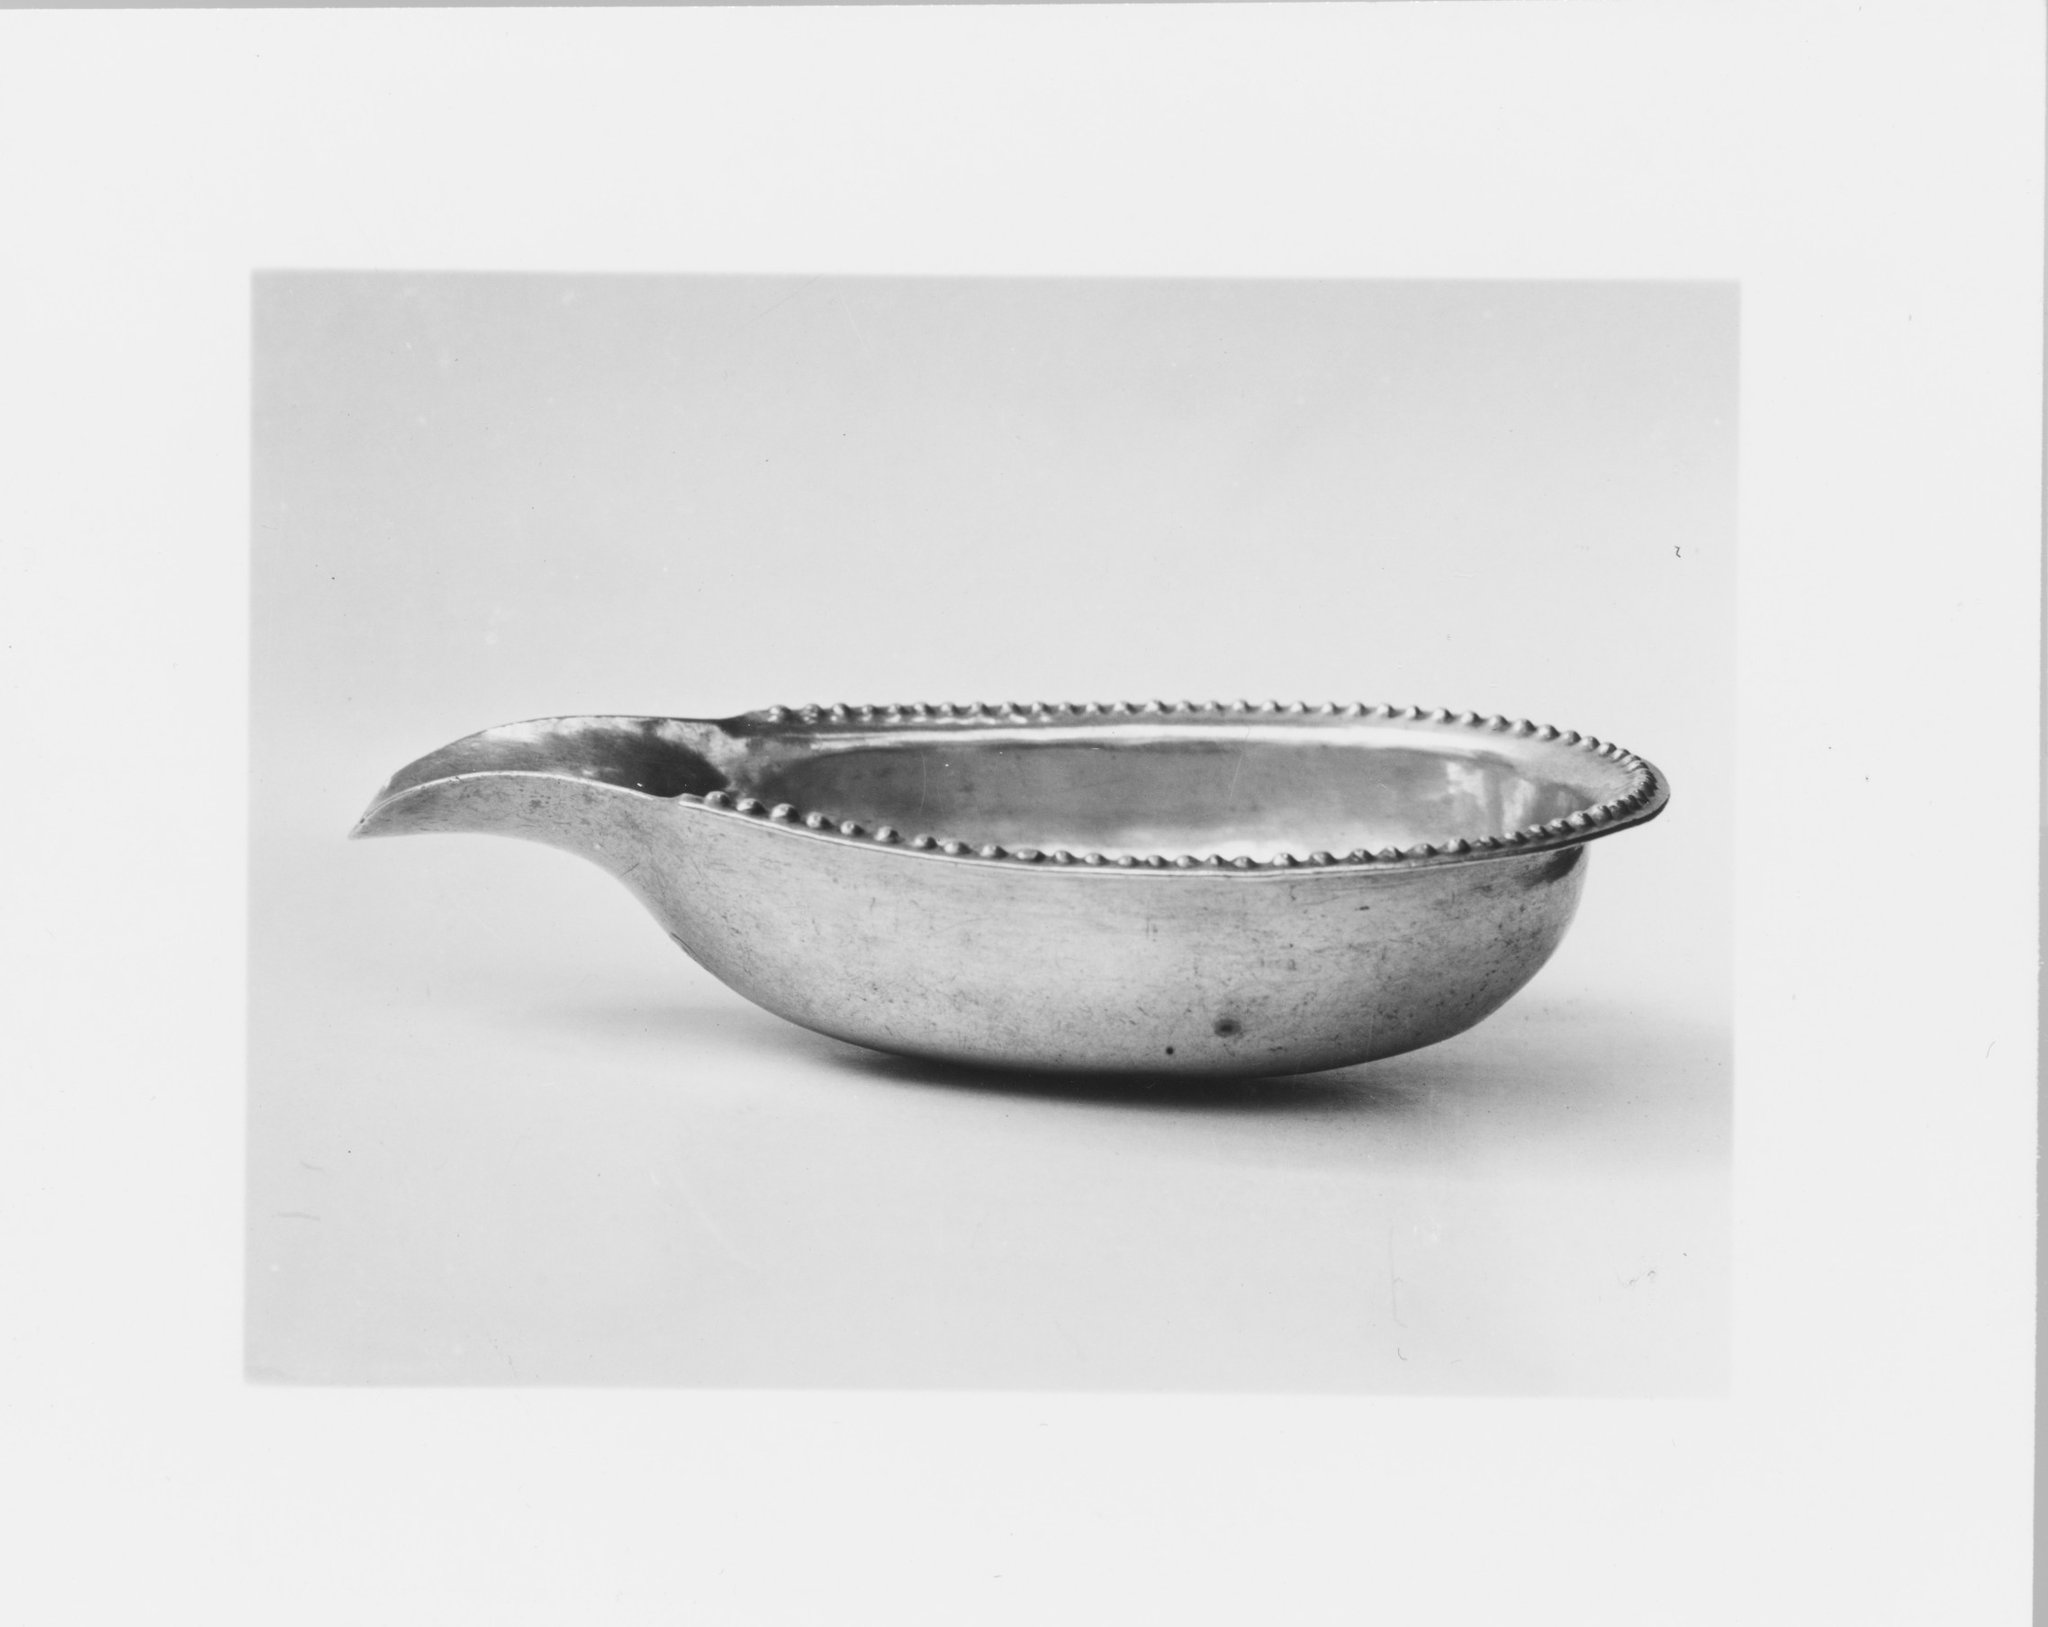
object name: pap boat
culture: american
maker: joel sayre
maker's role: maker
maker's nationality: american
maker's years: 1778-1818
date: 1800-1830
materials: silver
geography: united states